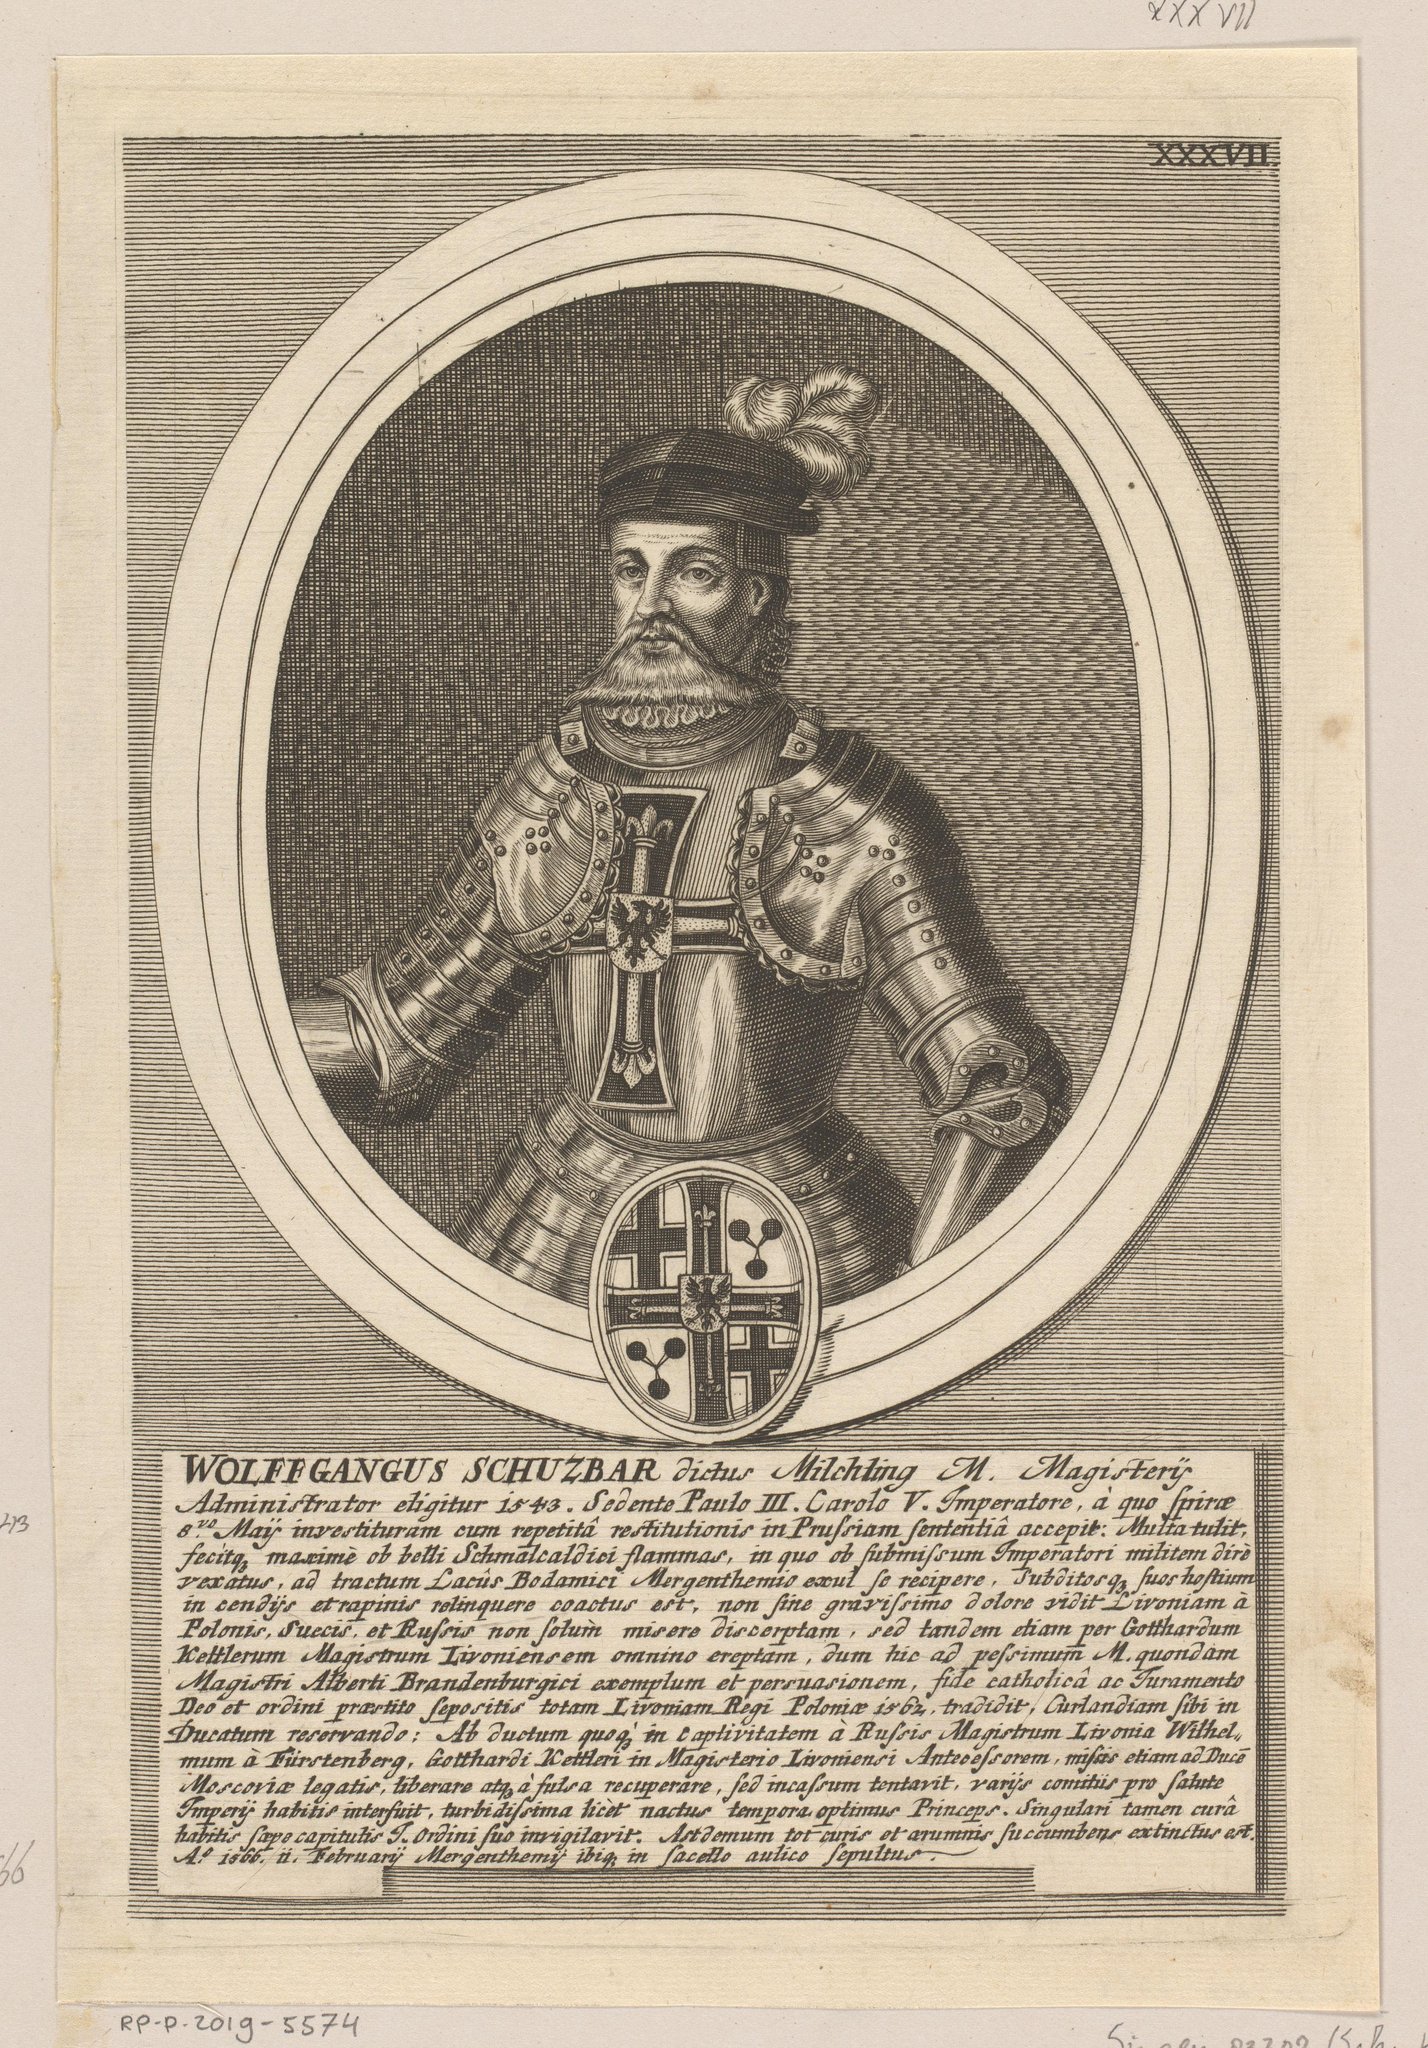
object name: book illustration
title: Portret van Wolfgang Schutzbar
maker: johann salver (i)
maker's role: print maker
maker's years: 1670-1738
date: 1720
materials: paper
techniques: engraving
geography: würzburg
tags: knighthood order: teutonic order - insignia of a knighthood order, e.g.: badge, chain (with name of order), armour, historical persons, armorial bearing, heraldry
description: Prent uit: [Salver, Johann]. De origine, secundis et adversis successibus, nec non de statu moderno inclyti ordinis equestris hospitalis b.m.v. Teutonicorum in Jerusalem. Würzburg: Johann Salver, [ca. 1720].